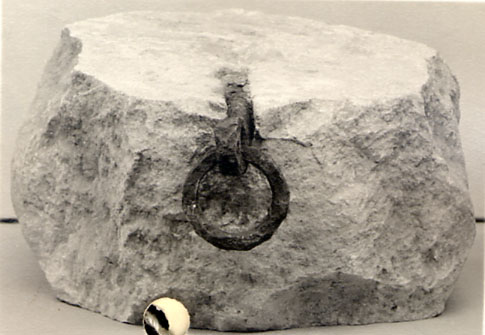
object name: block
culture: french or german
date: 1201-1300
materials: stone